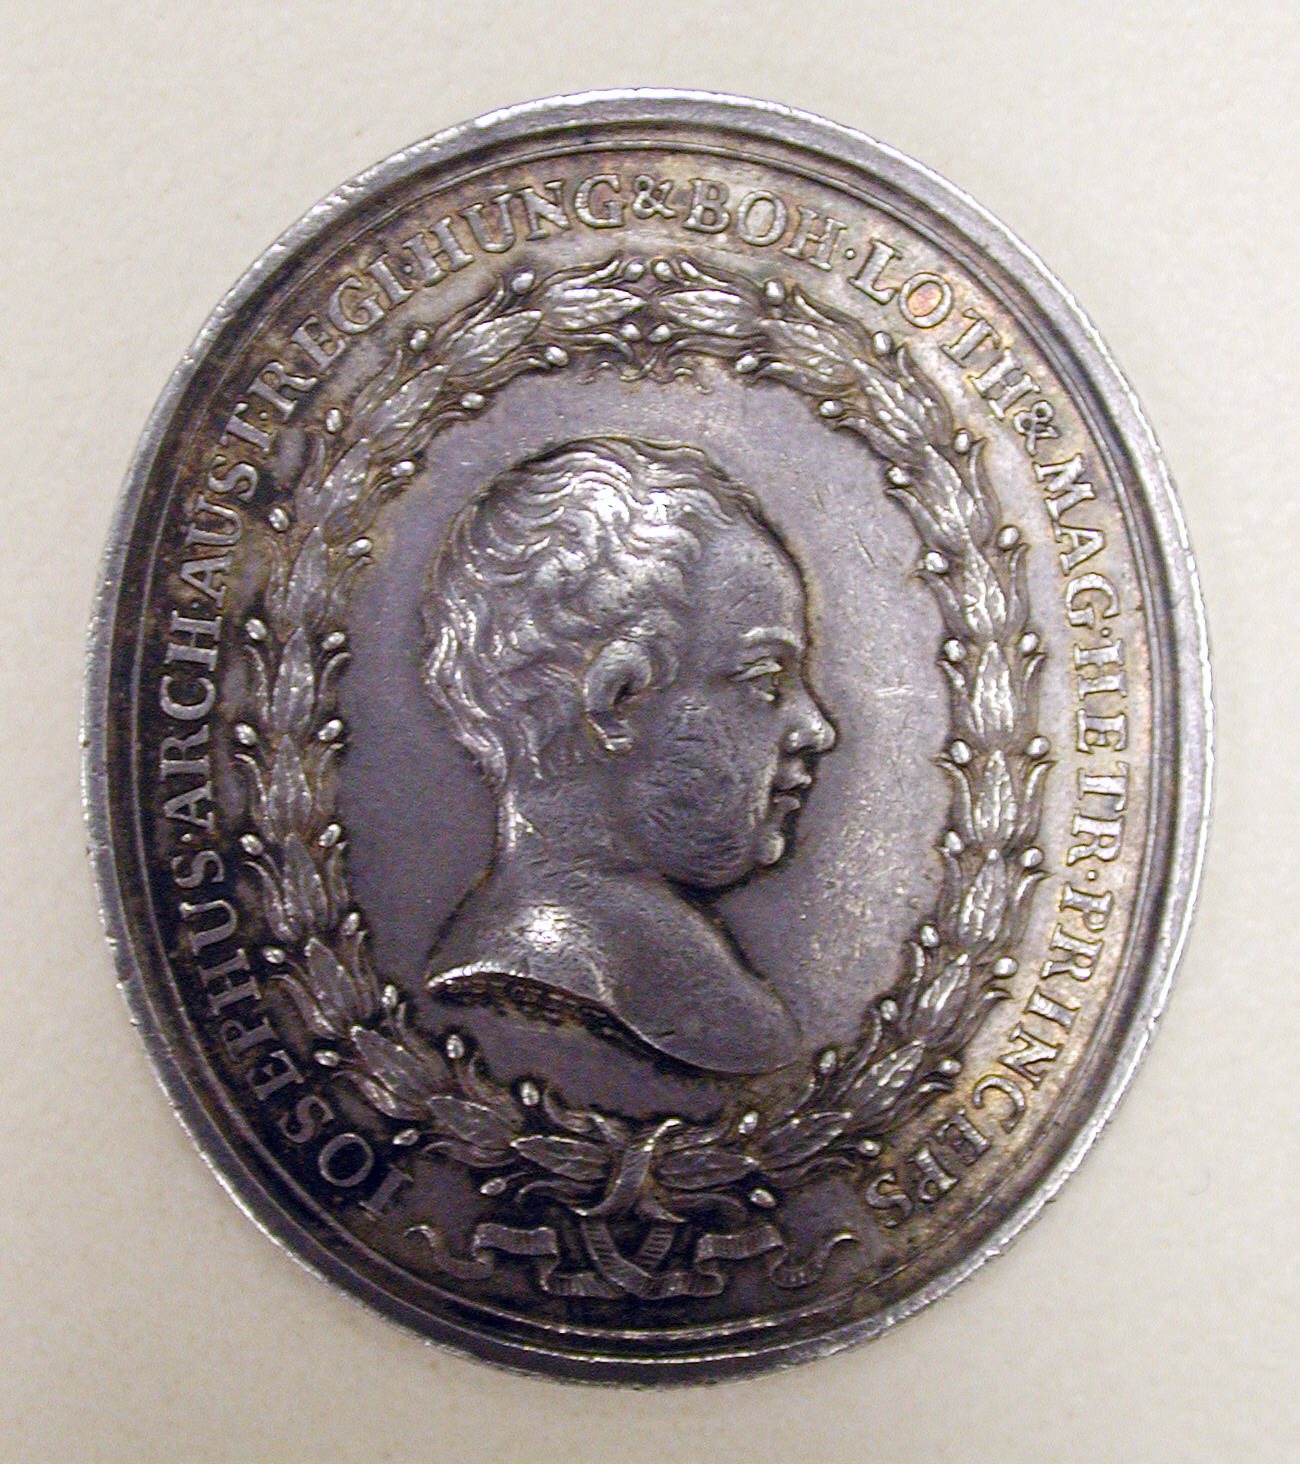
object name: medal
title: The Birth of Archduke Joseph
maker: d. becker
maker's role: maker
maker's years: 1700-1800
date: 1741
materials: silver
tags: men,profiles